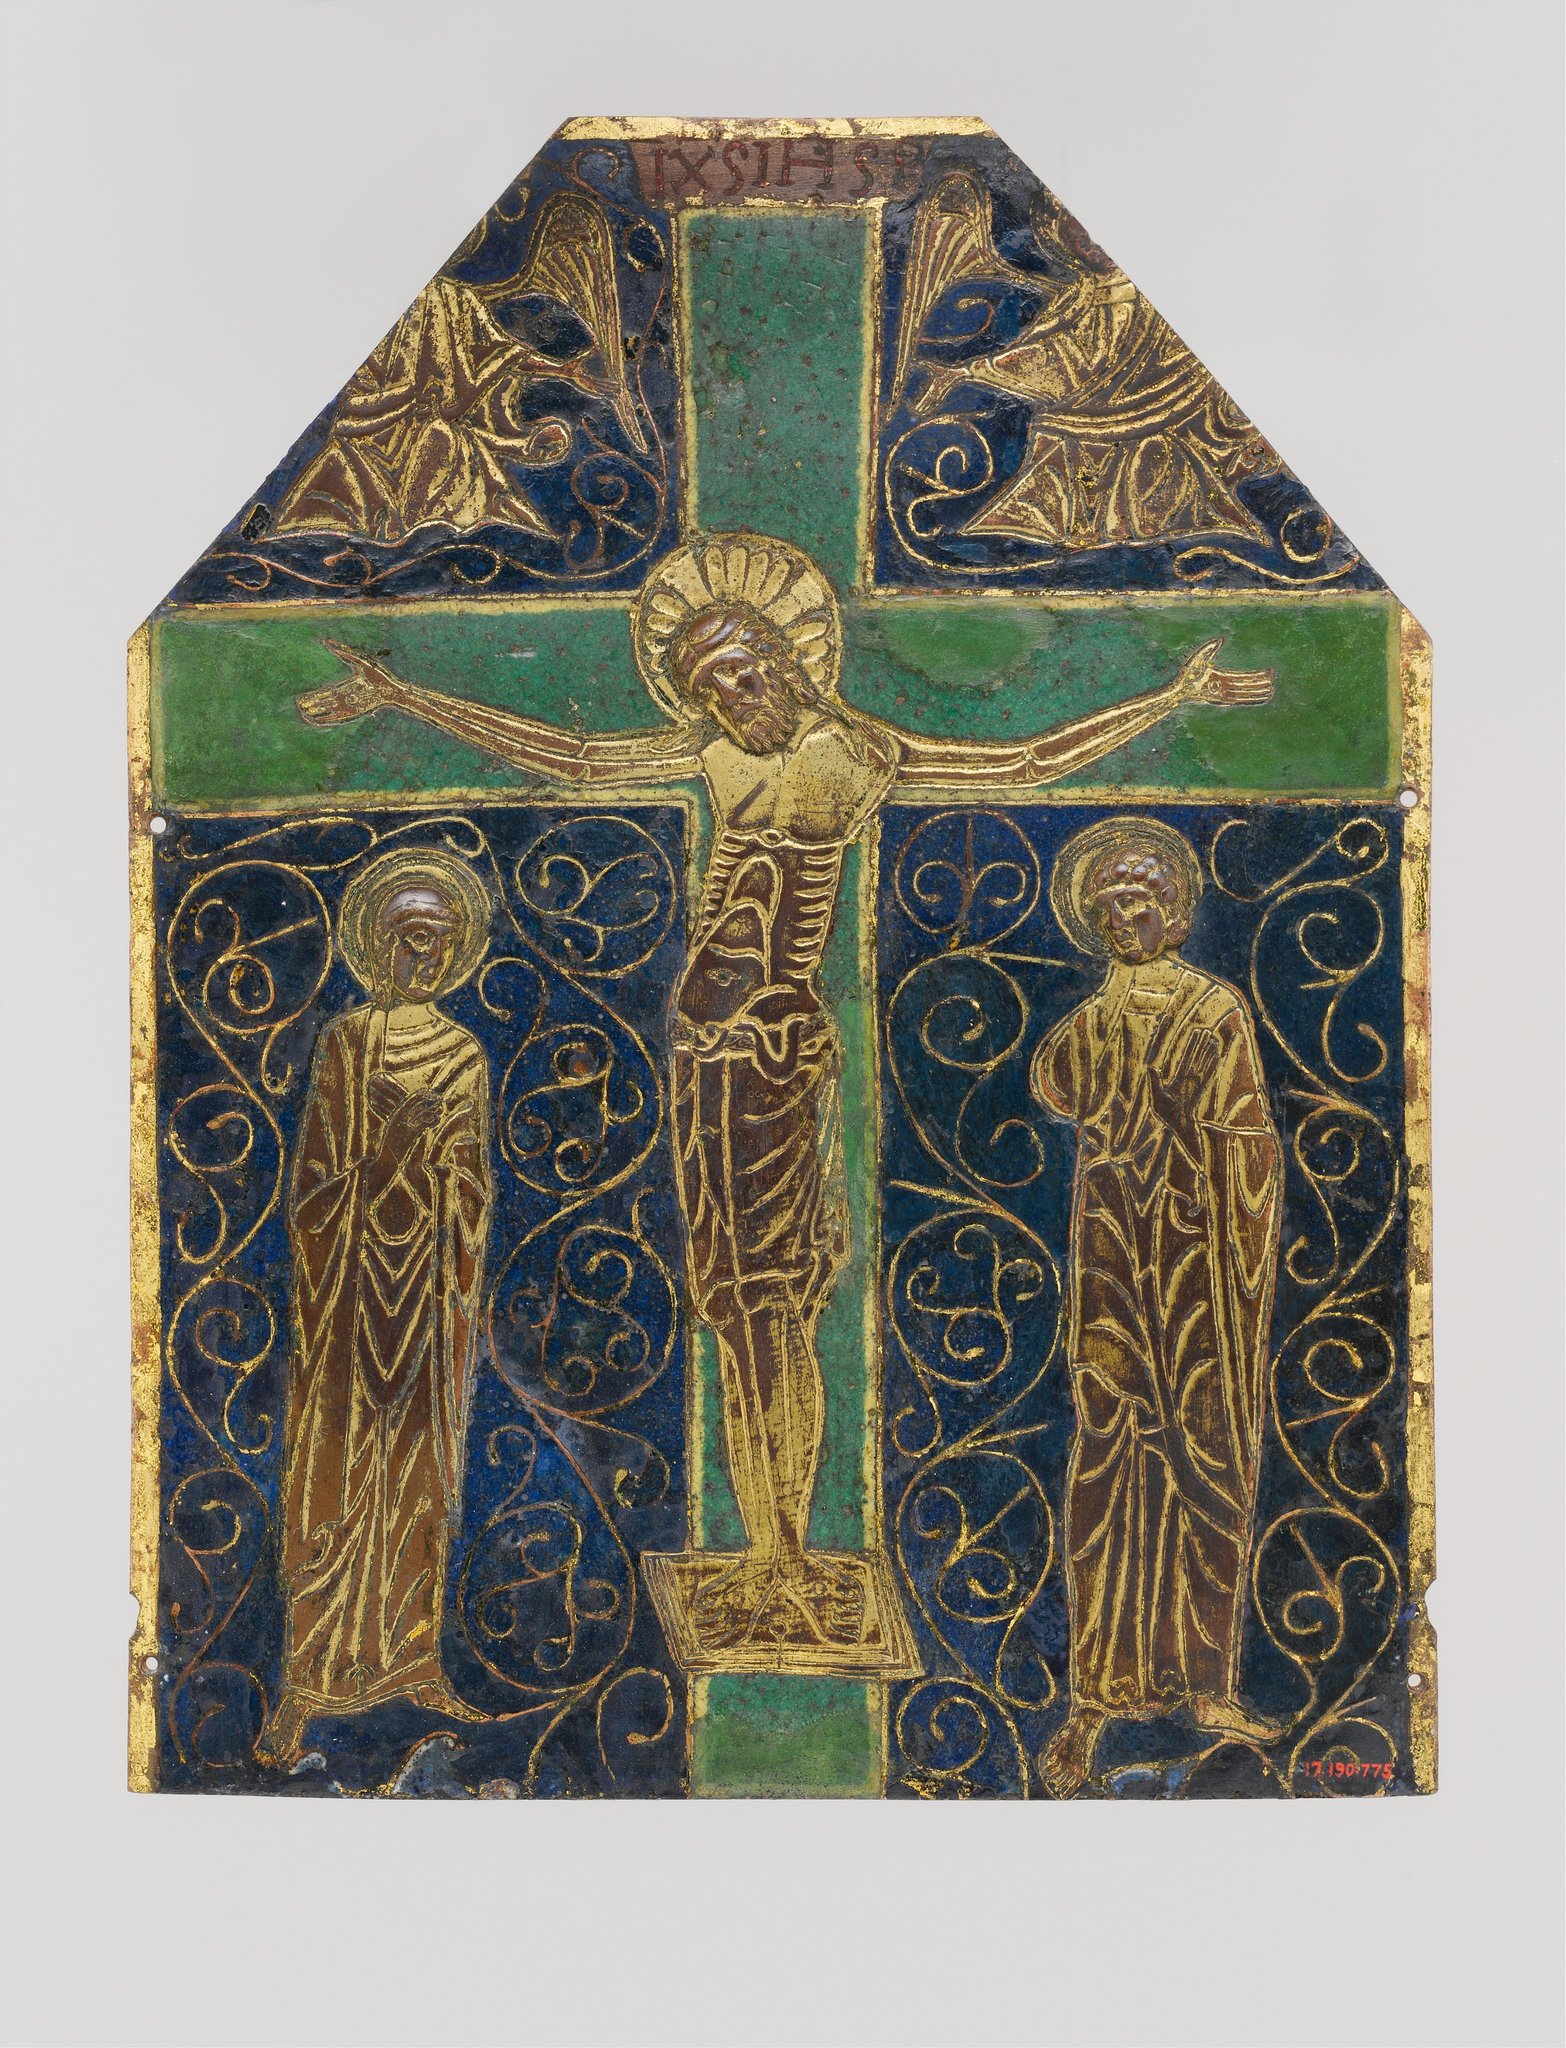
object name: plaque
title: Plaque with the Crucifixion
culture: french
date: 1201-1300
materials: gilt copper, enamel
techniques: enamel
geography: france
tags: christ,cross